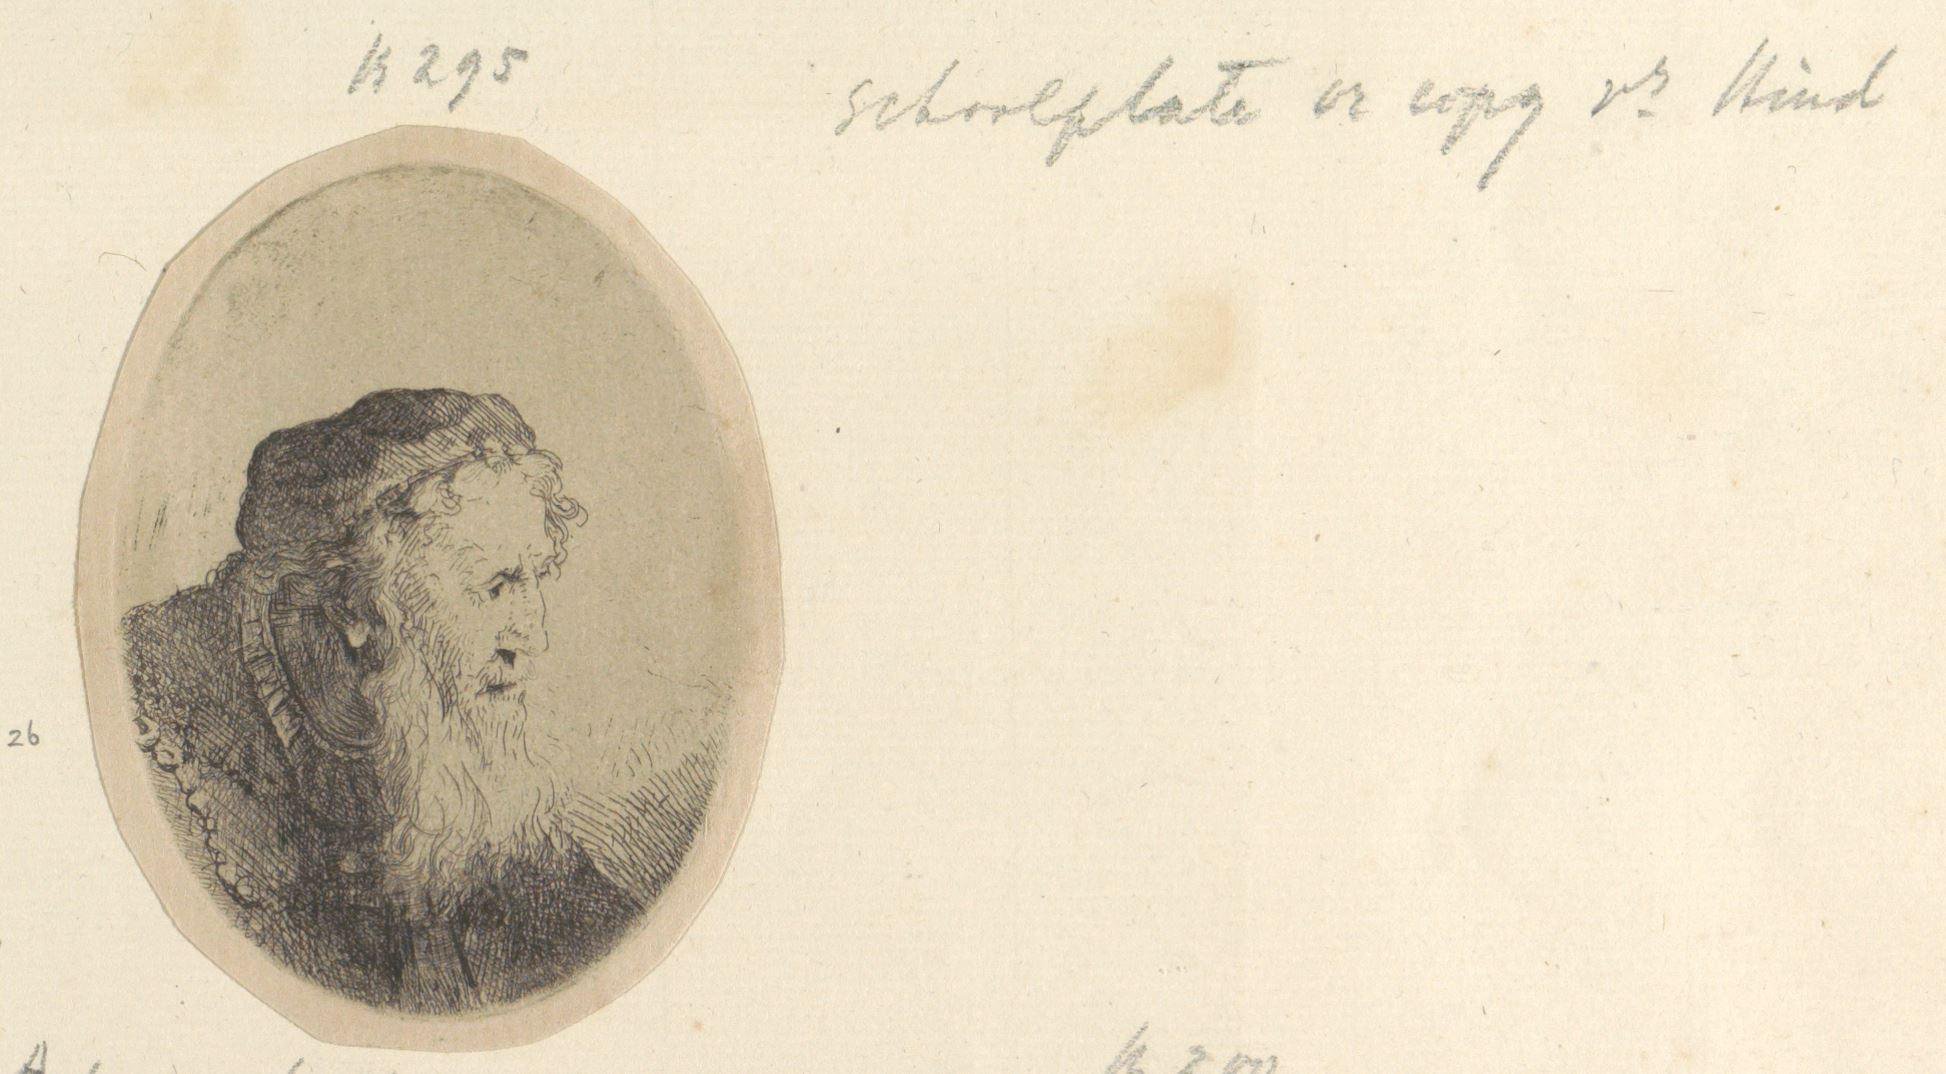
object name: print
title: Oude man met baard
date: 1626-1680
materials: paper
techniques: etching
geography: paris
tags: old man